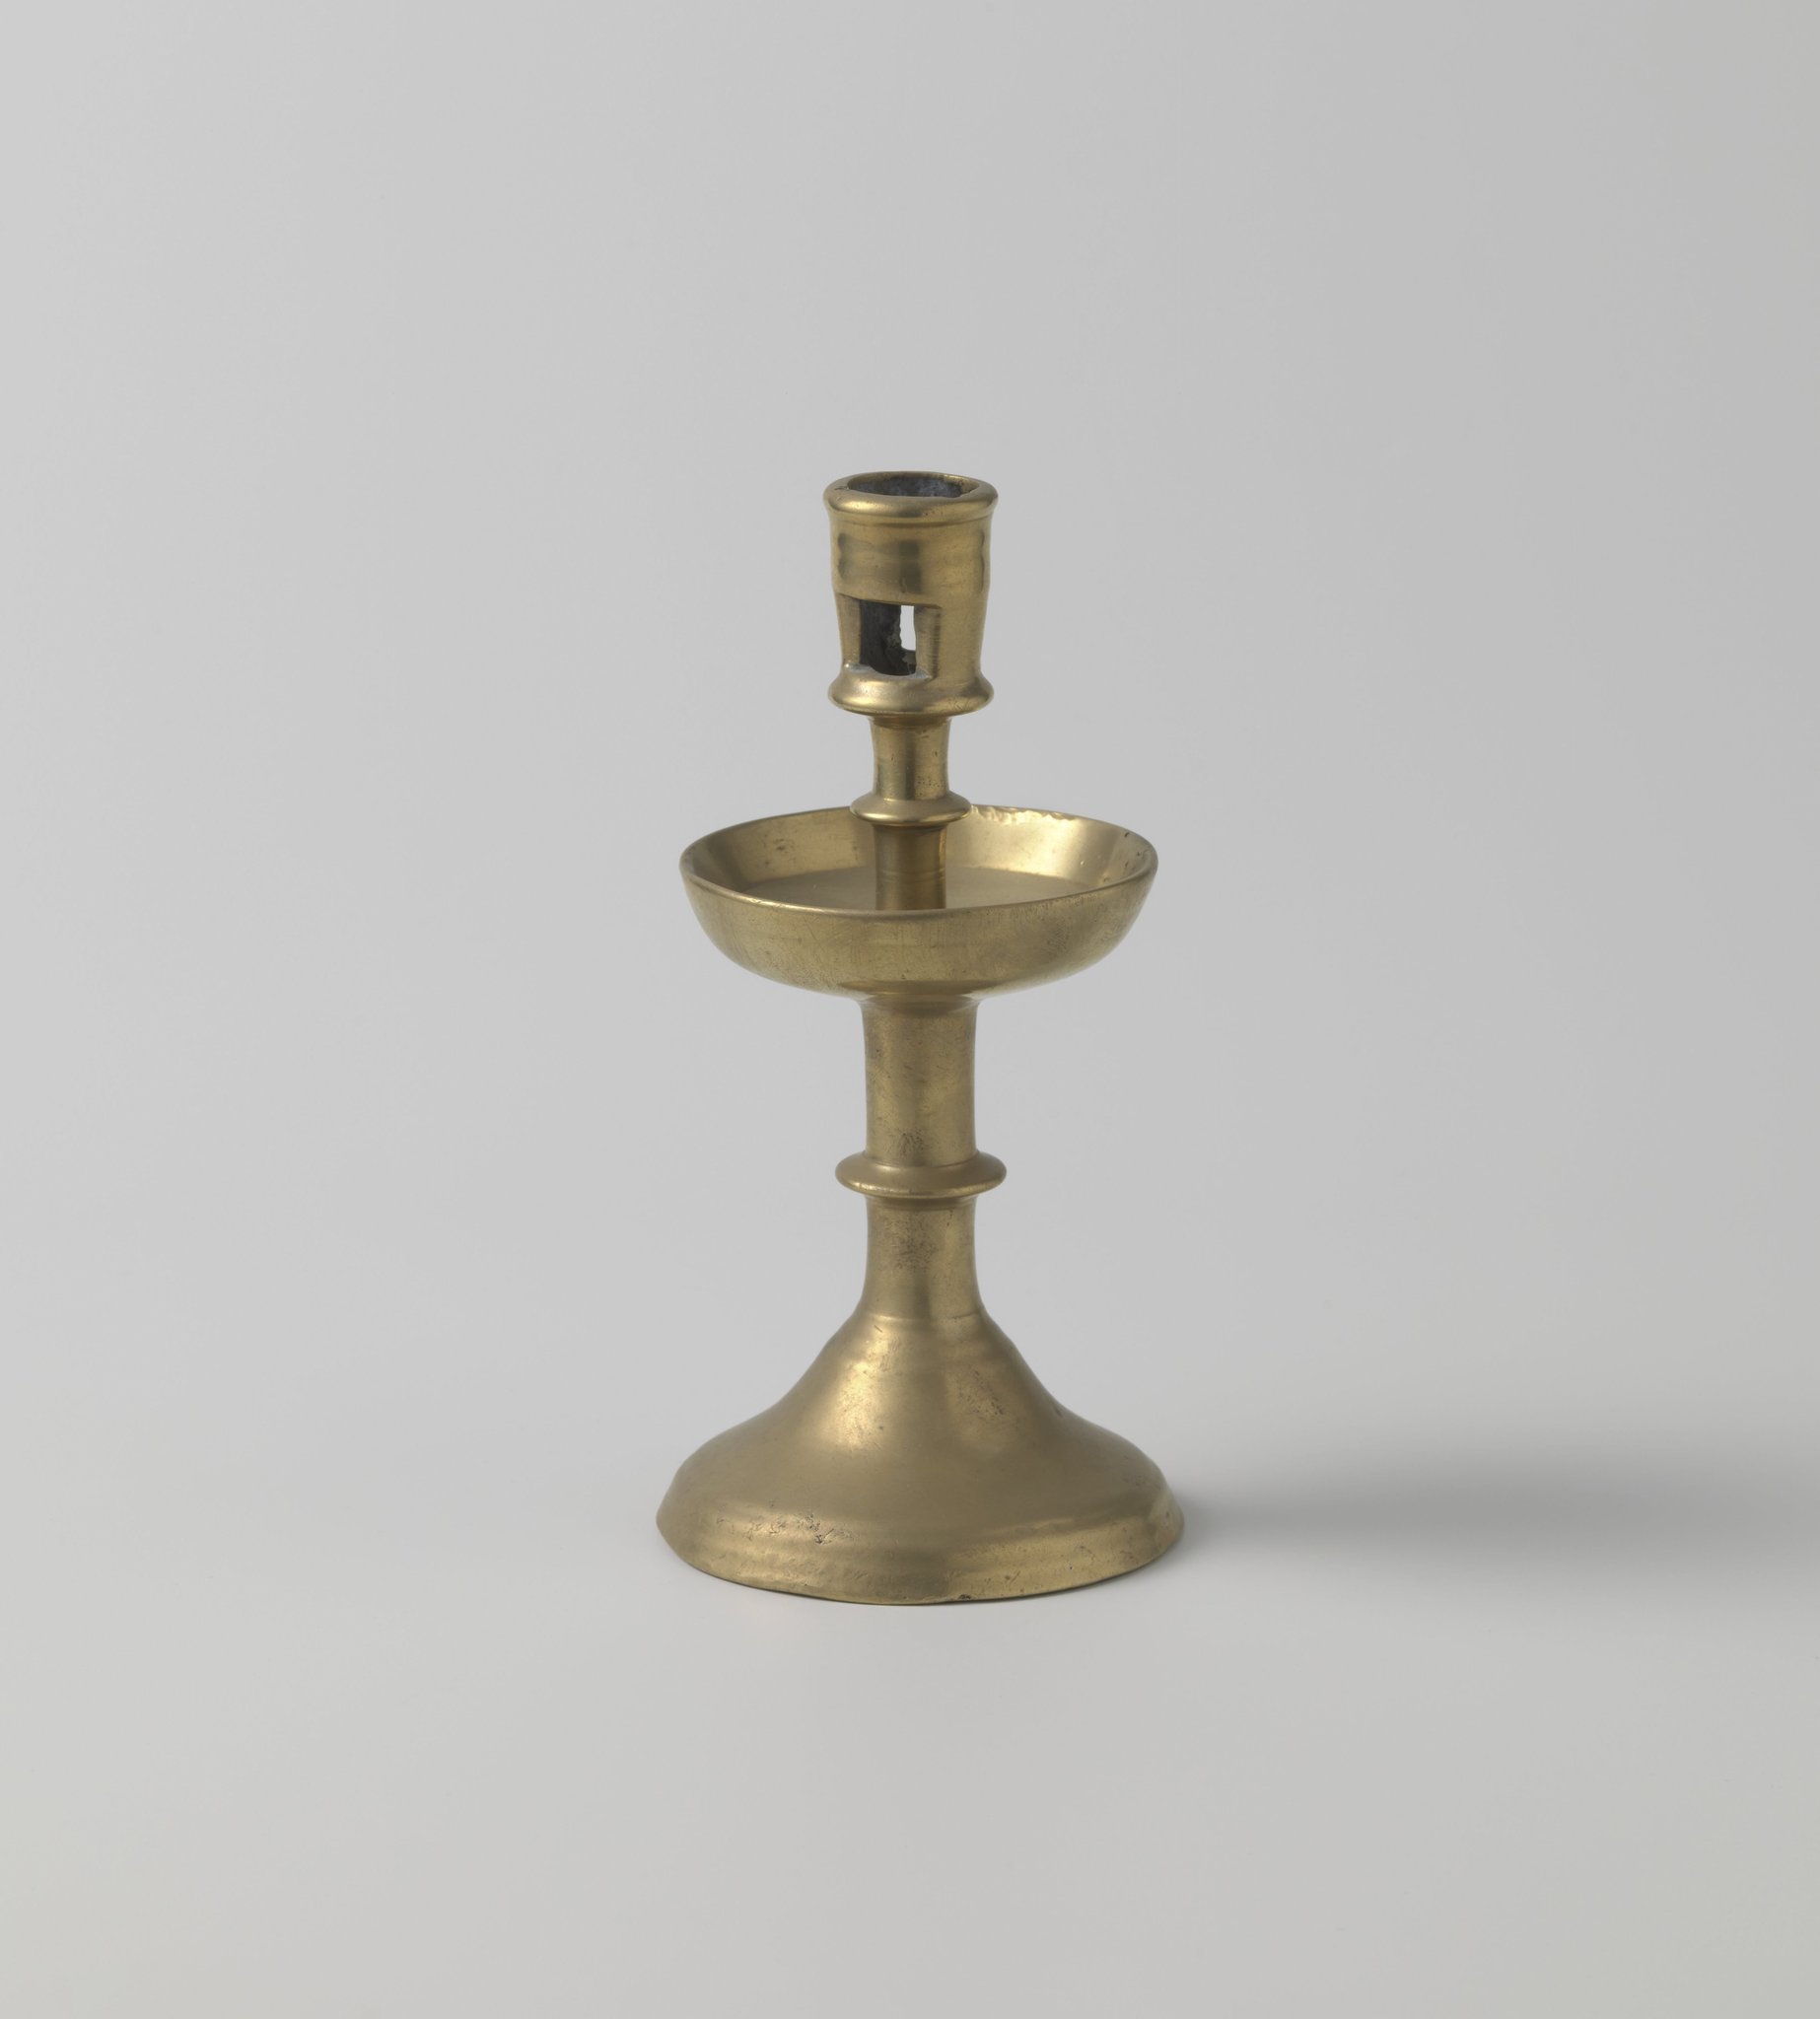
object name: candlestick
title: Kraagkandelaar van messing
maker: Anonymous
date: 1475-1525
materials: brass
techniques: casting, riveted, turning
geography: southern netherlands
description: De kandelaar is samengesteld uit twee gegoten en afgedraaide delen: de voet met het onderste deel van de stam en de vetvanger, en het bovenste deel van de stam met de kaarsenhouder. Dit laatste deel loopt uit in een pin, die onder in de voet is geklonken. De naar het midden toe oplopende voet is met rillen versierd, de stam is versierd met een knoop halverwege de voet en de tot een kraag uitgegroeide vetvanger. De geprofileerde cylindrische houder heeft in de wand twee rechthoekige openingen, die in elkaars verlengde liggen.